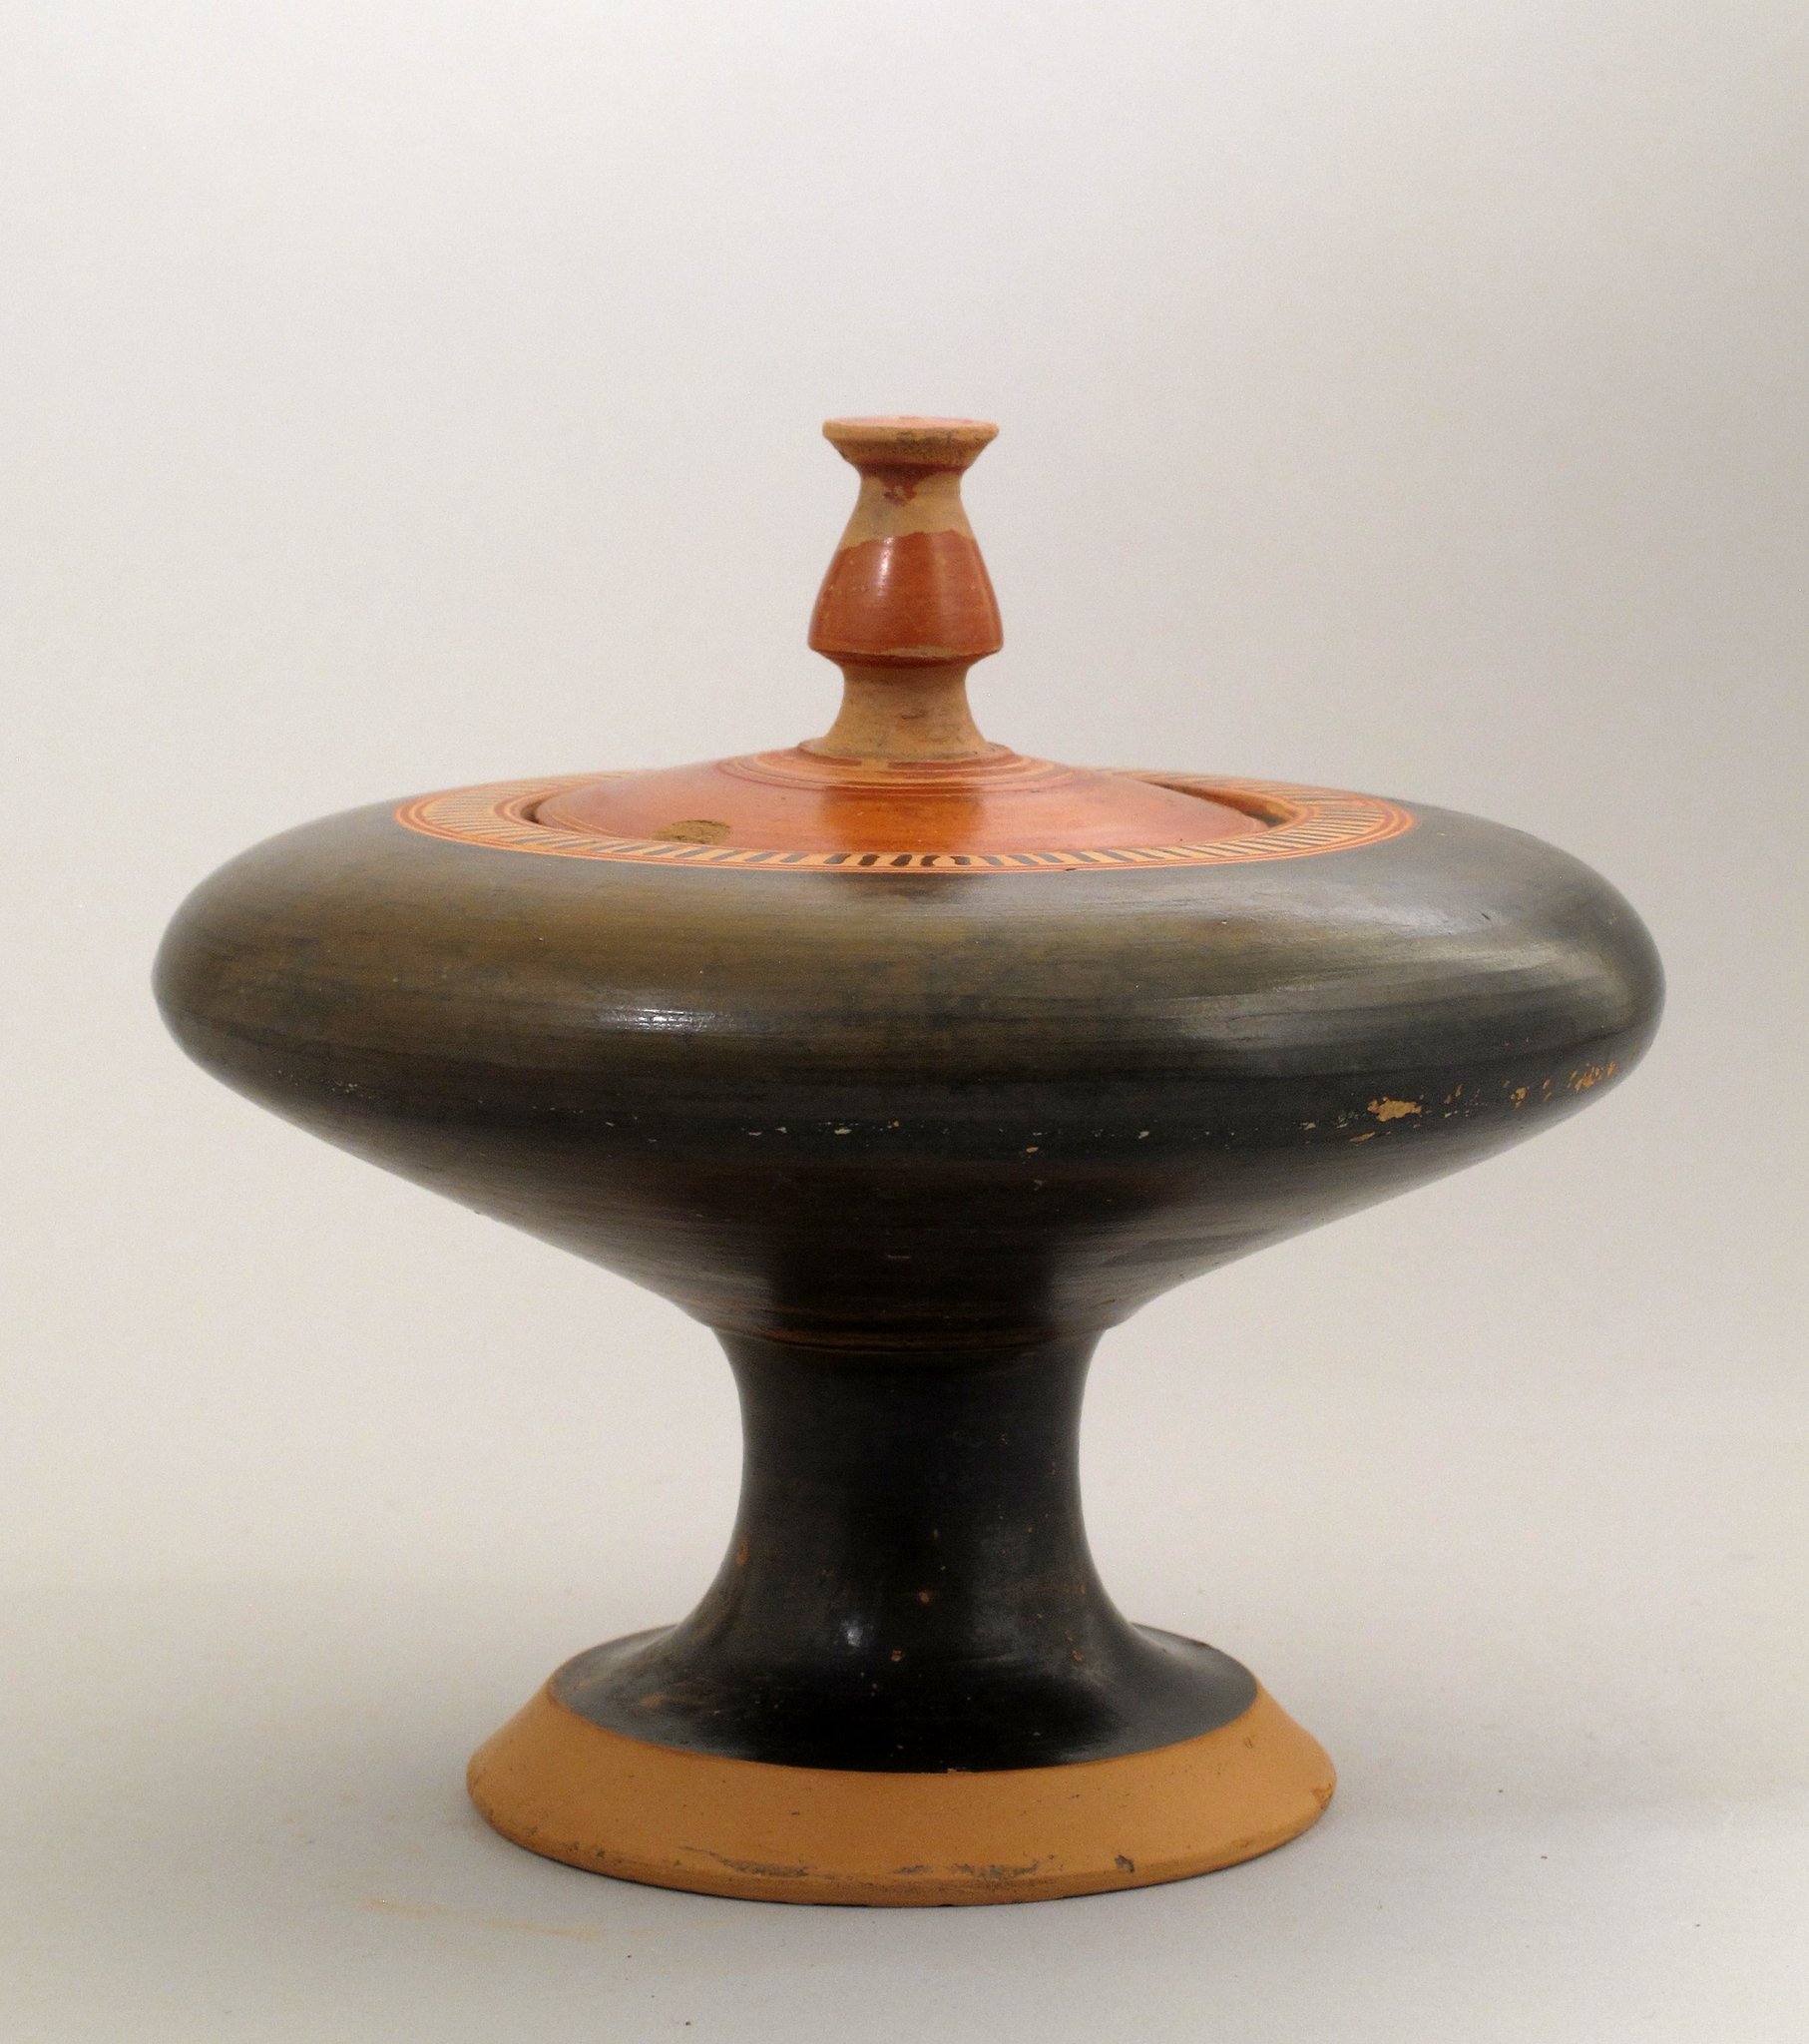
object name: plemochoe with lid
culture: greek, attic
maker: kothons type b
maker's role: artist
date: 534-501 BCE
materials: terracotta